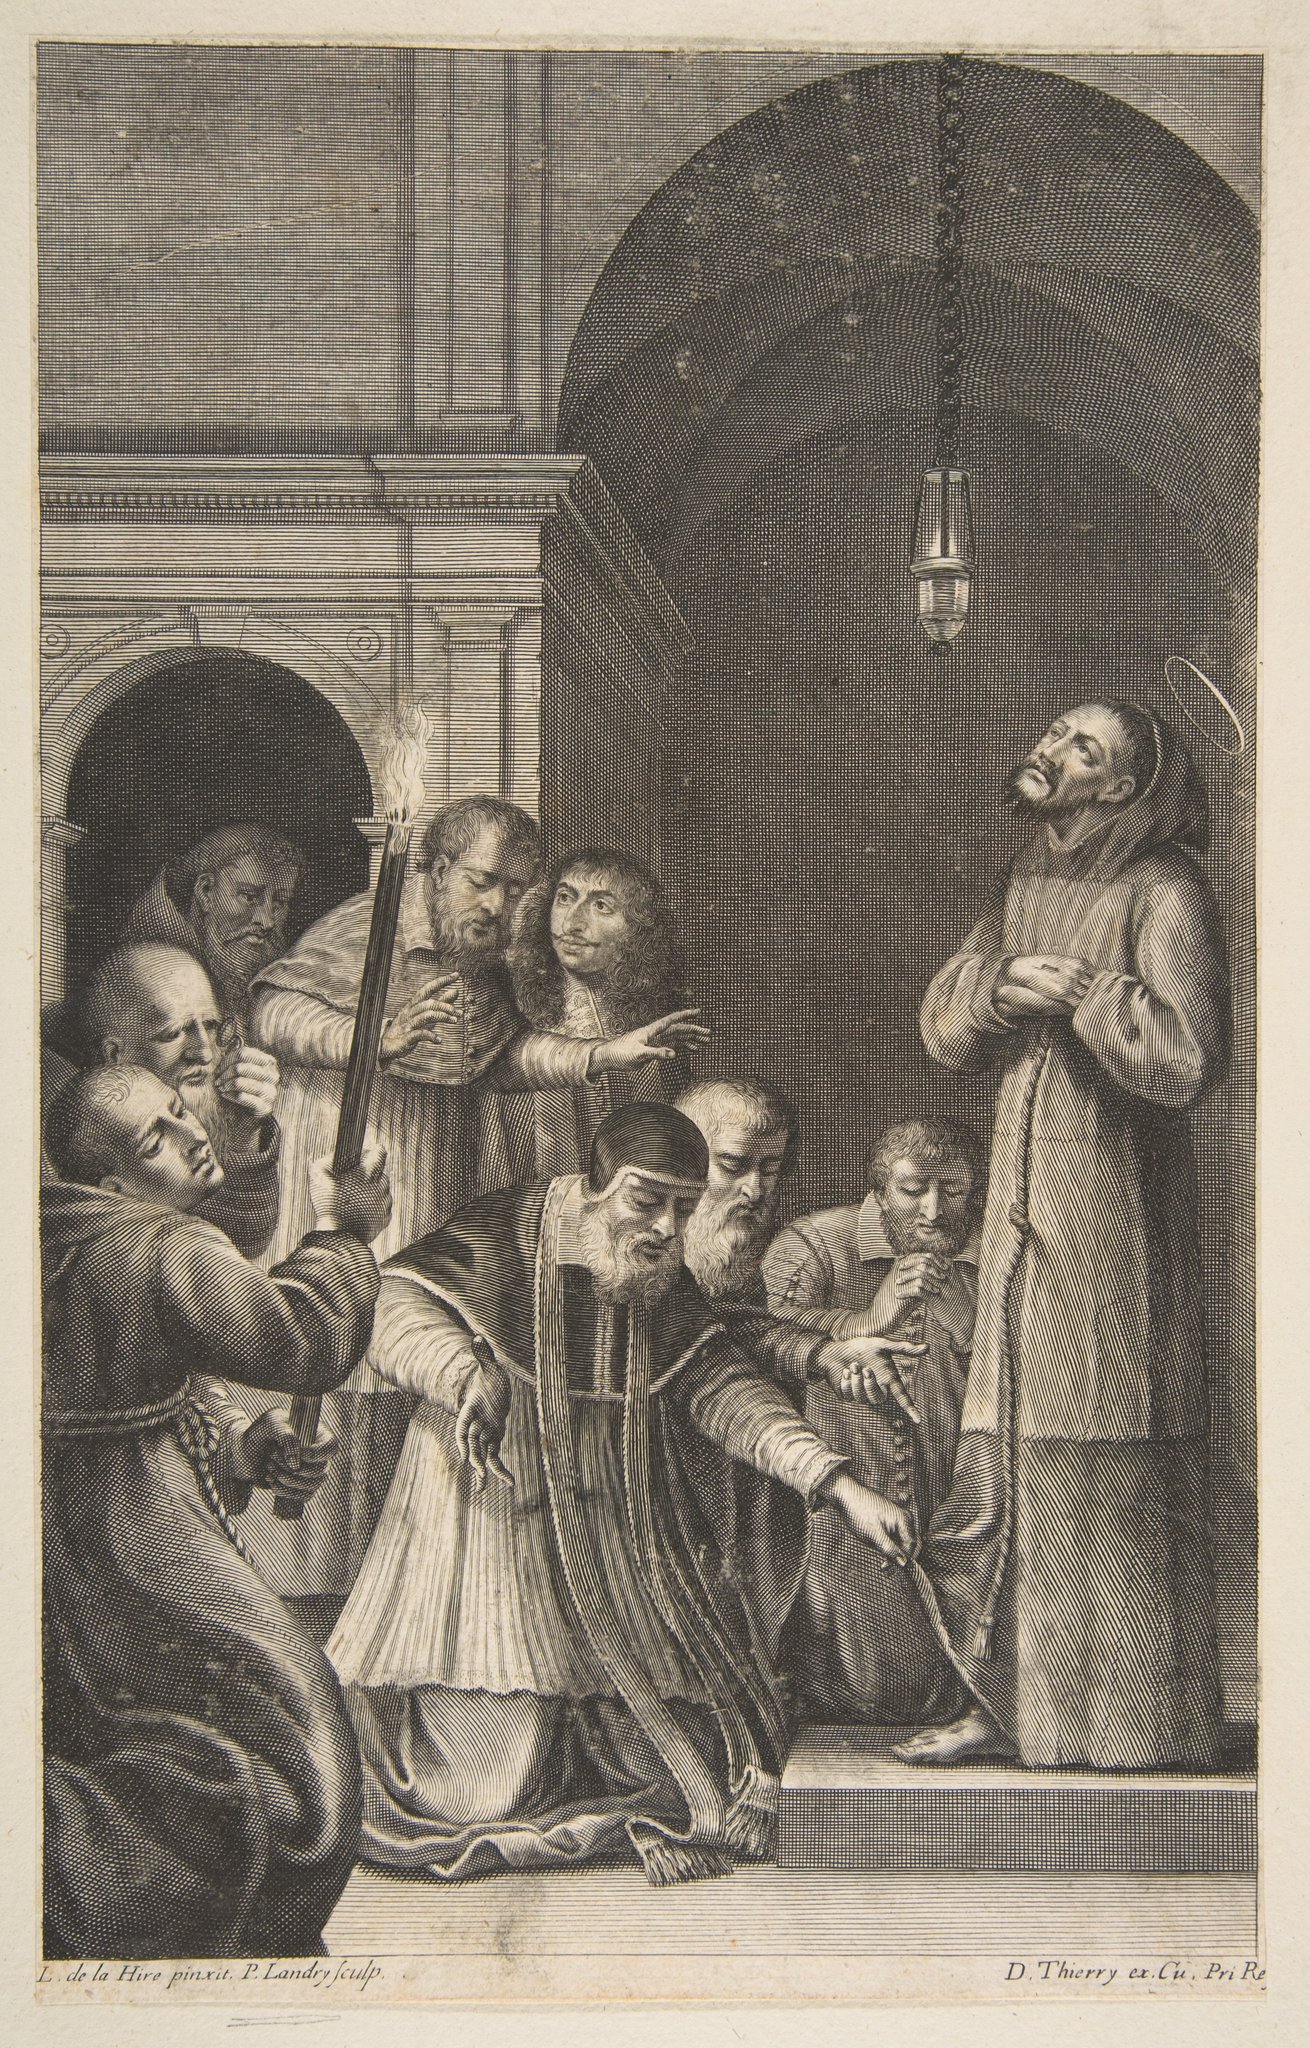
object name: print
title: St. Francis (?)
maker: pierre landry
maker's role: artist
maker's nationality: french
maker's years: 1630-1701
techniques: engraving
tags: men,saints